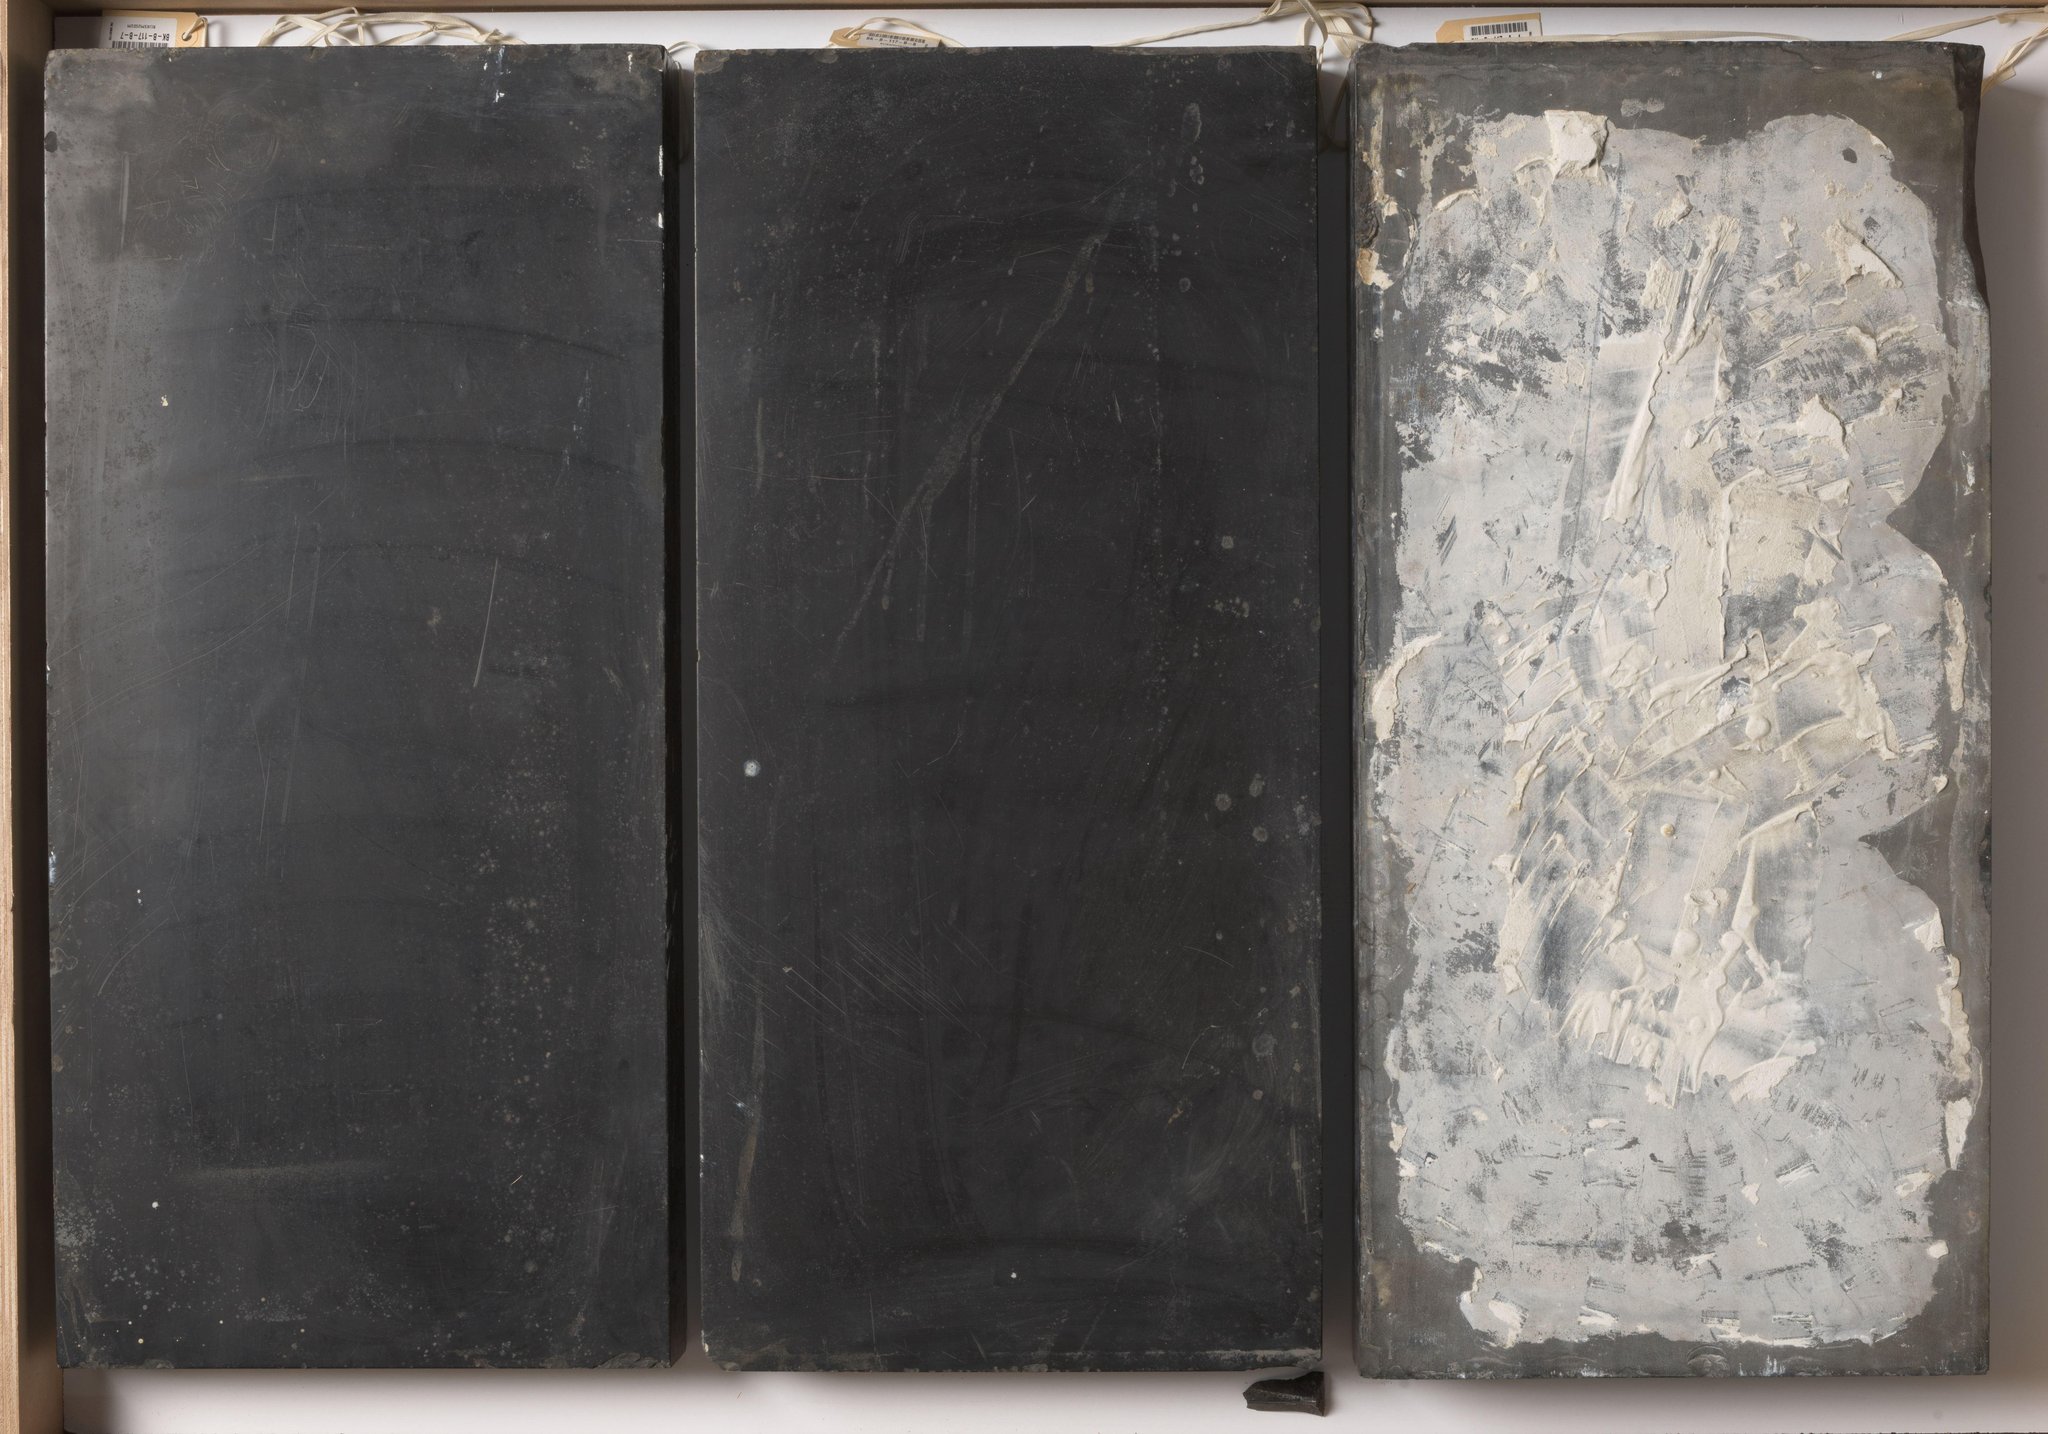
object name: plate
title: Rechthoekige plaat van zwart hardsteen met opschrift, behorend bij Paardentemmer (Cheveaux de Marly)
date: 1894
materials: brick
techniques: carved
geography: paris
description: De rechthoekige plaat van zwart hardsteen gemaakt voor de lange zijde van de sokkel waar op BK-B-117-A of B stond. Hoogstwaarschijnlijk de onderzijde of één van de twee korte zijden van de sokkel.